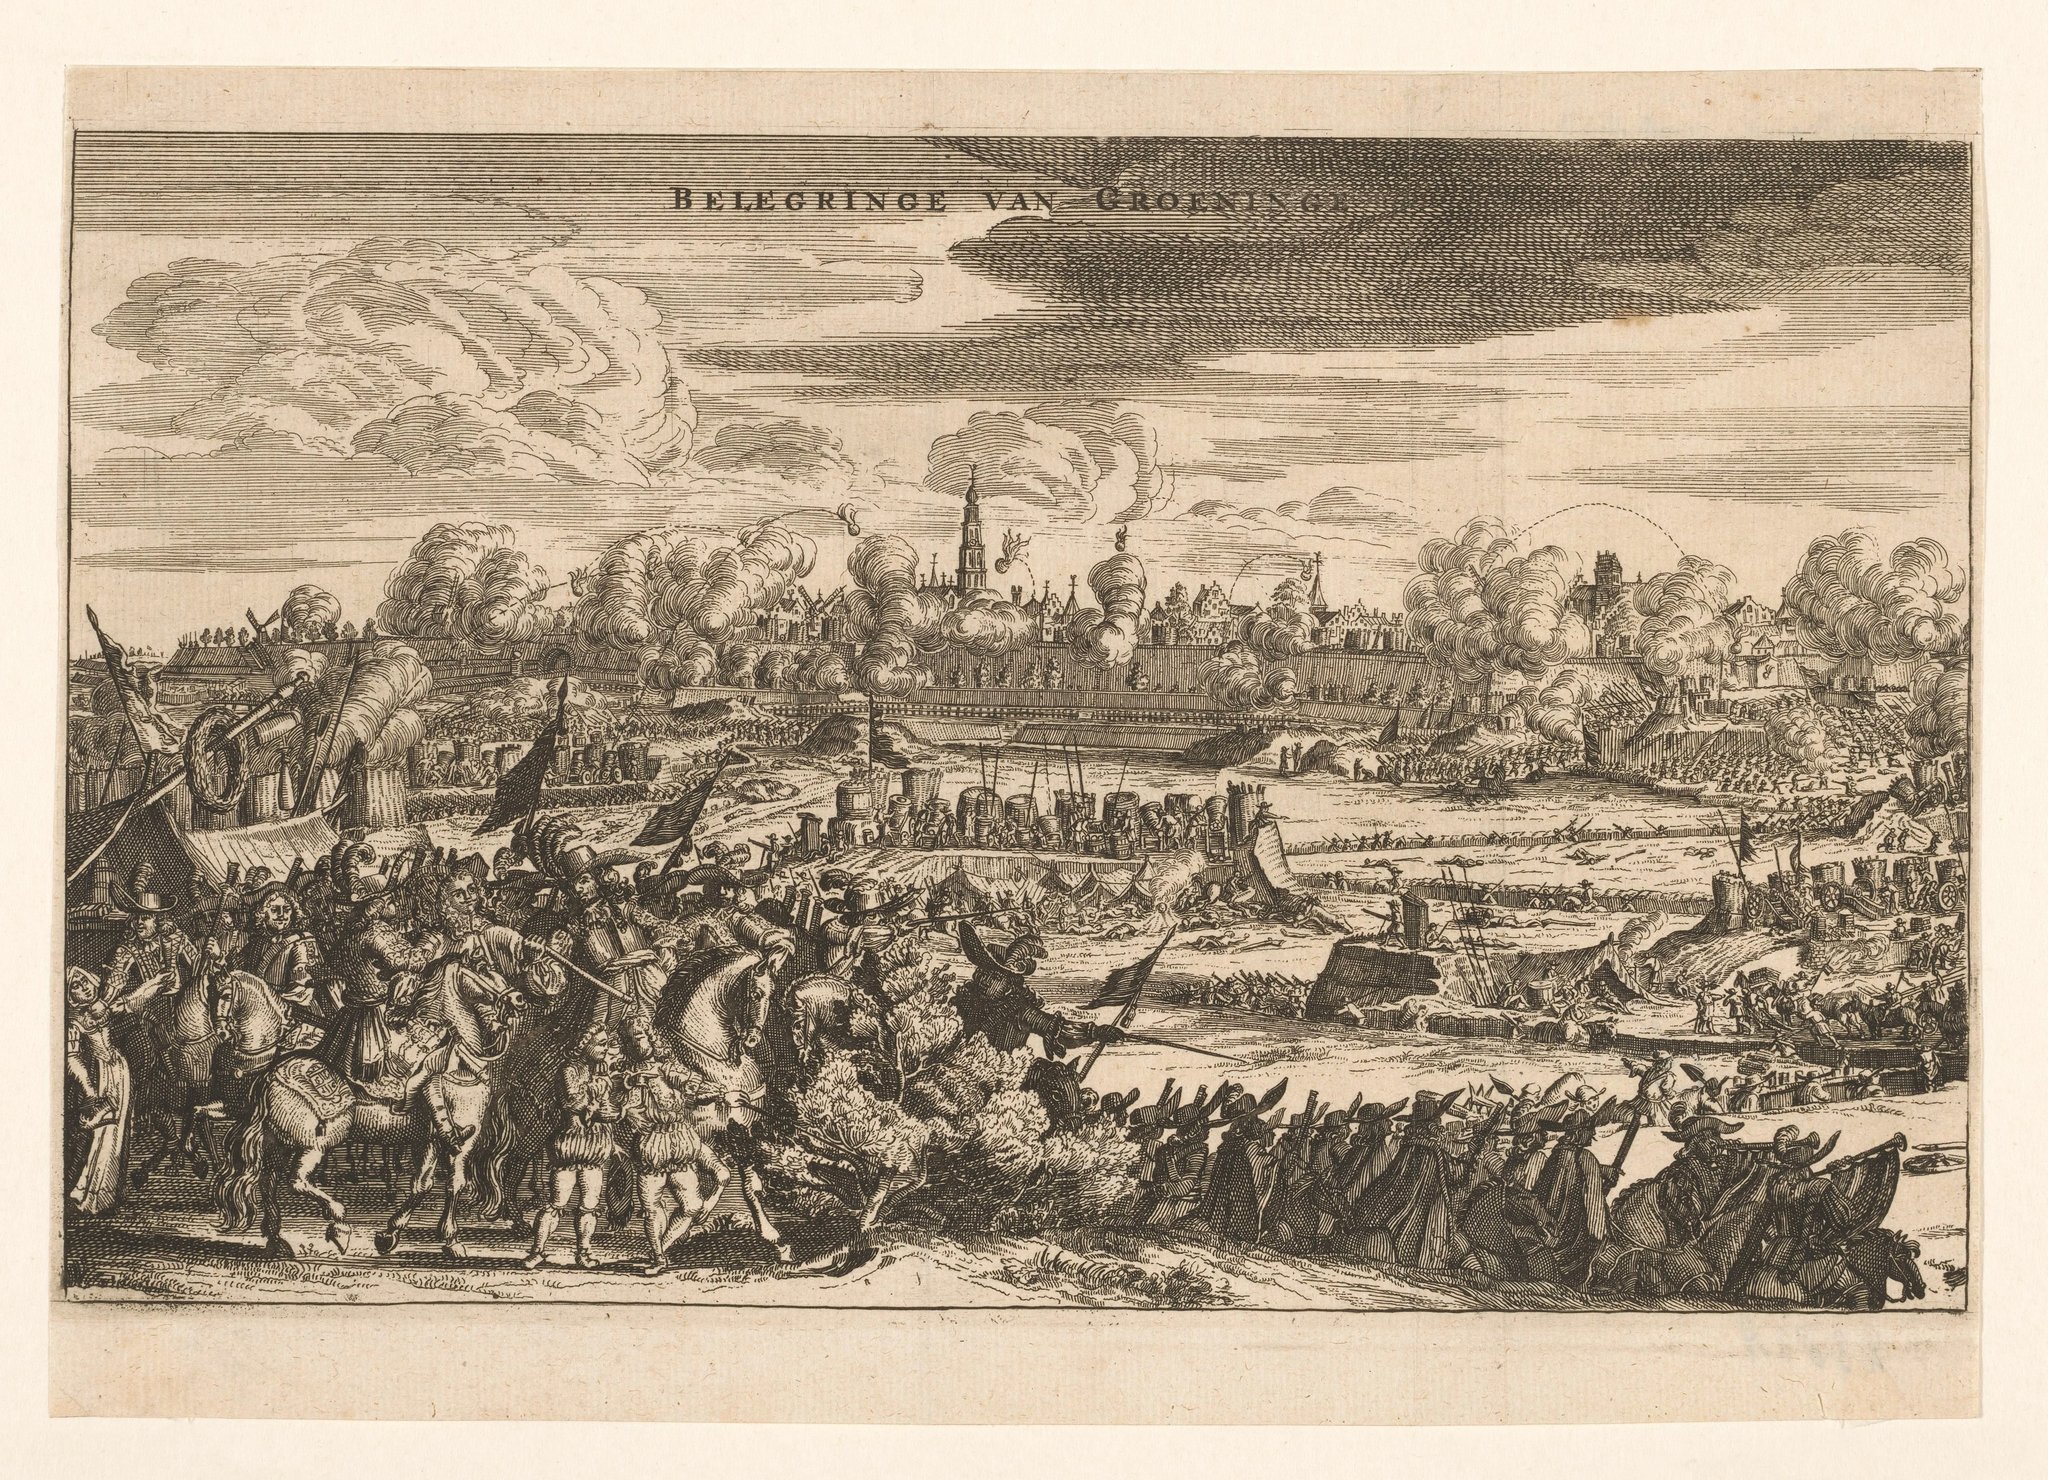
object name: print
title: Beleg van Groningen, 1672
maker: Anonymous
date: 1672-1674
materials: paper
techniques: etching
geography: northern netherlands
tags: siege, position war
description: Gebruikt als illustratie in T. van Domselaer, Het ontroerde Nederlandt, door de wapenen des konings van Vrankryk, 2 dln, M. Willemsz. Doornik, Amsterdam 1674-1676, dl. I, p. 354 en is gekopieerd naar de illustratie uit Lambert van den Bosch, Tooneel des oorlogs, Amsterdam 1675 (FMH 2385), die weer is overgenomen van de prent van Romeyn de Hoogh (FMH 2383).